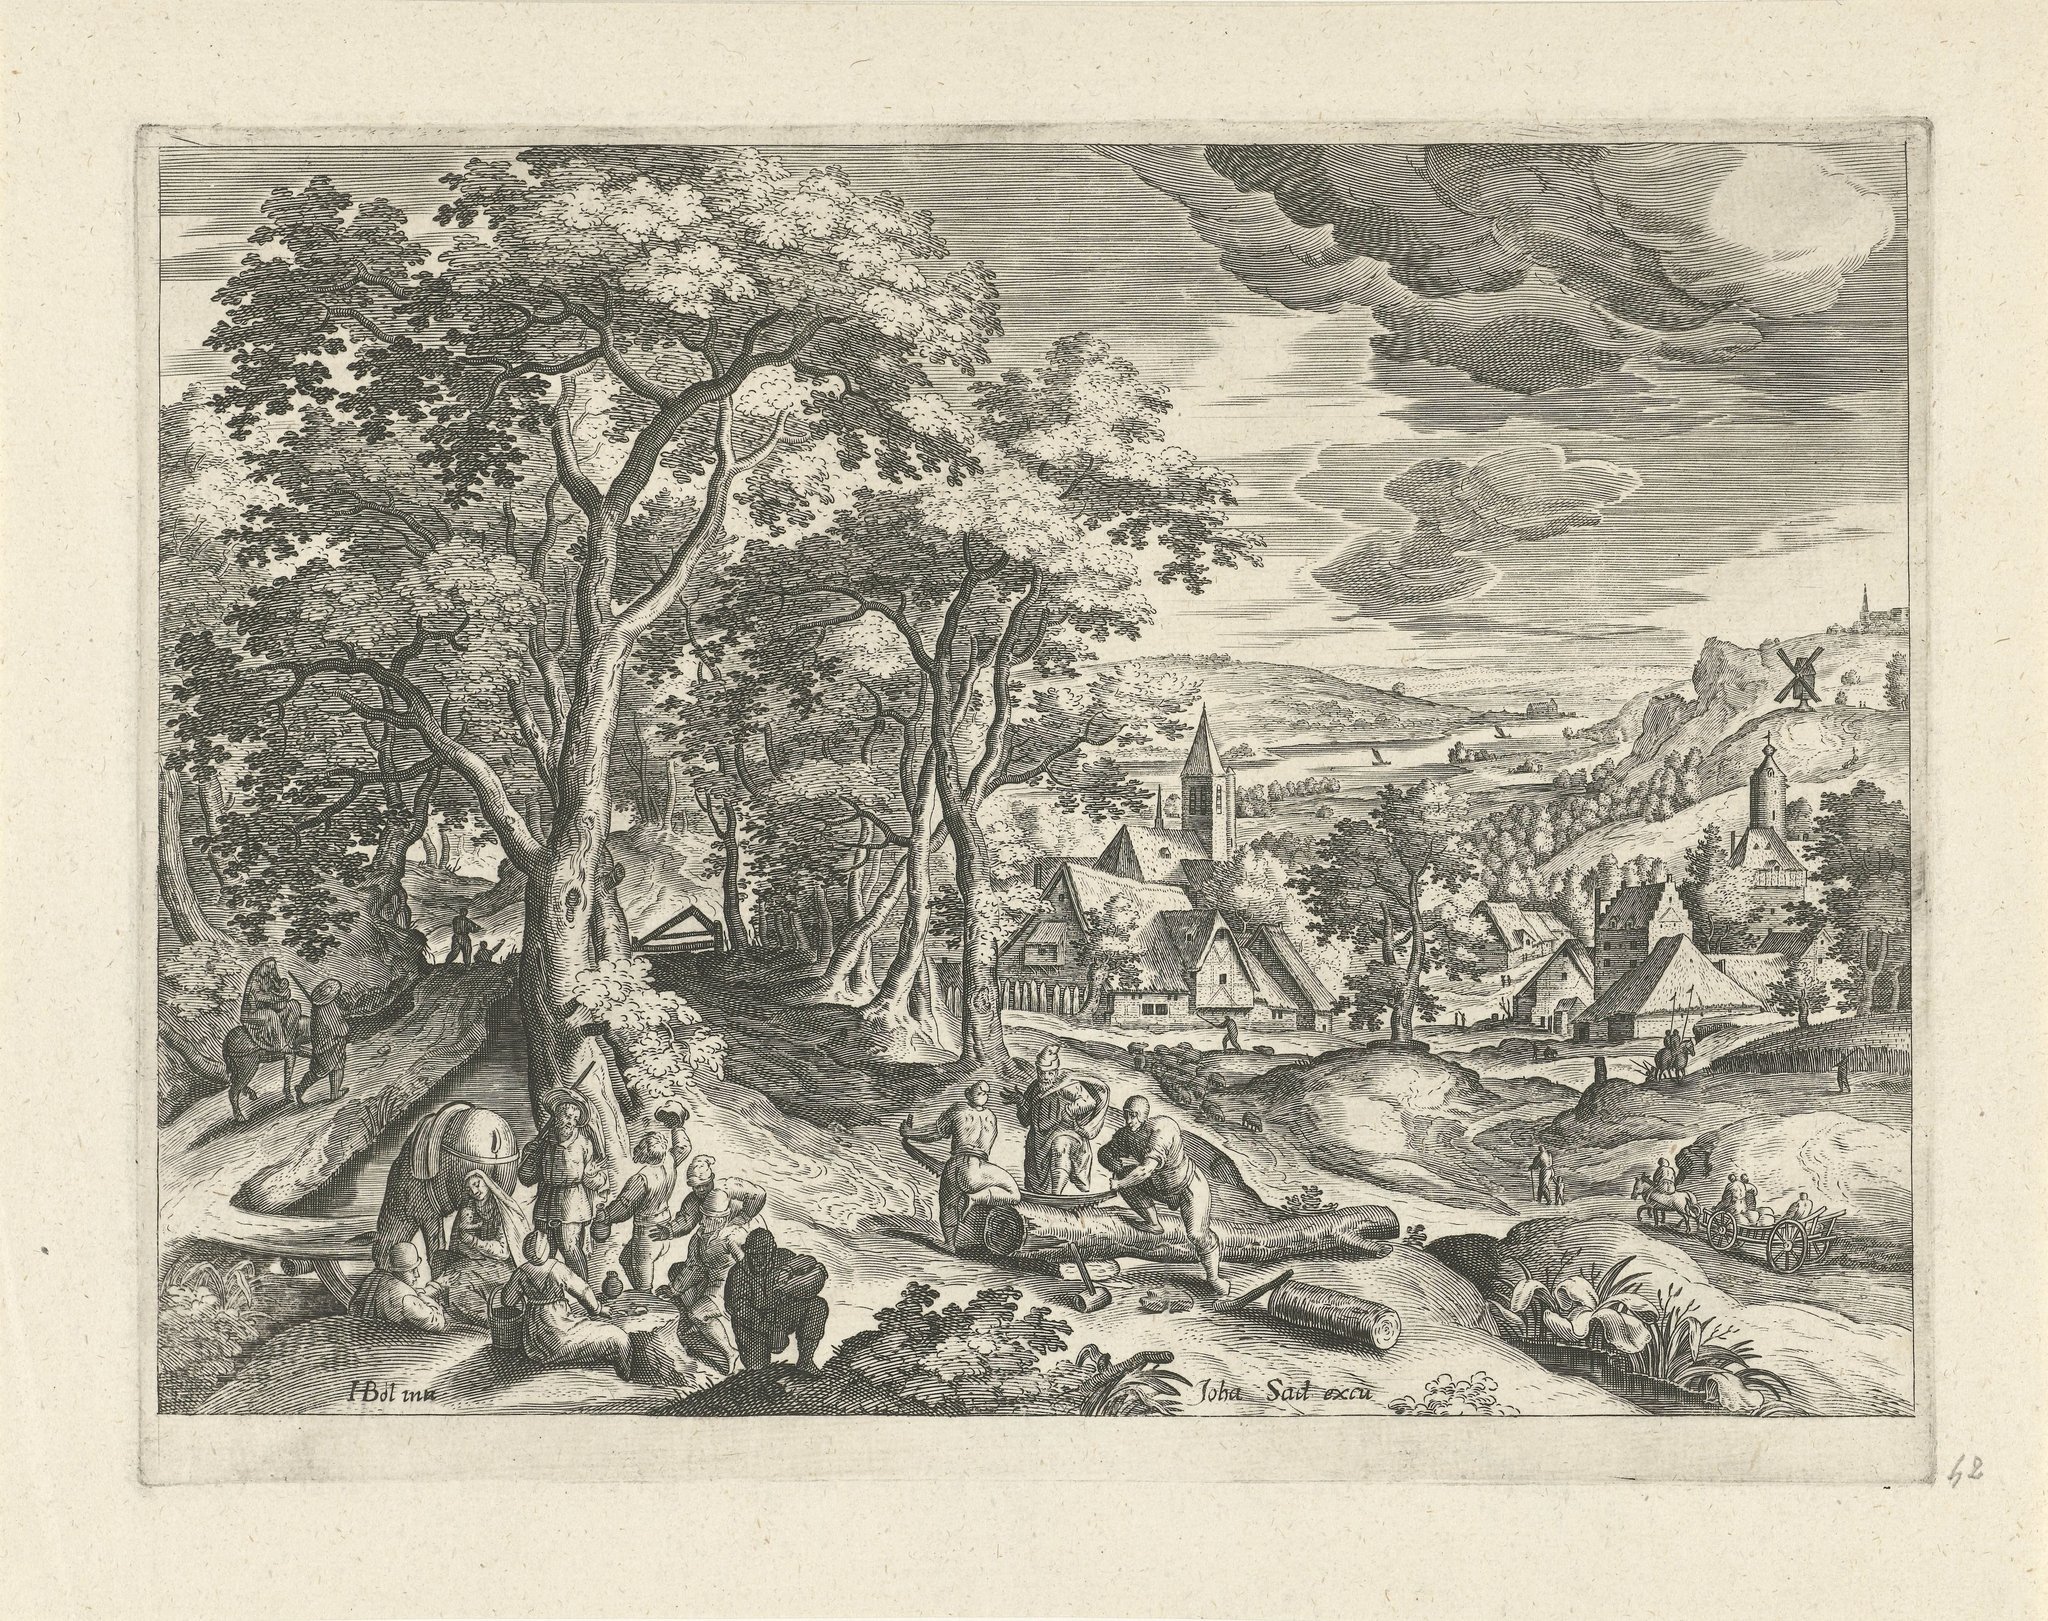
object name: print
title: Landschap met de rust op de vlucht naar Egypte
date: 1580-1600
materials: paper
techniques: engraving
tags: the flight into egypt: mary, joseph, the child (and sometimes others) on their way; mary usually riding on an ass, village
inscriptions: collector's mark: Lugt 2228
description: Een landschap met een dorp op de achtergrond. Op de voorgrond Maria en Jozef met het Christuskind, rustend bij de weg samen met andere reizigers. De prent is deel van een achtdelige serie van landschappen met scènes uit het Oude en Nieuwe Testament.